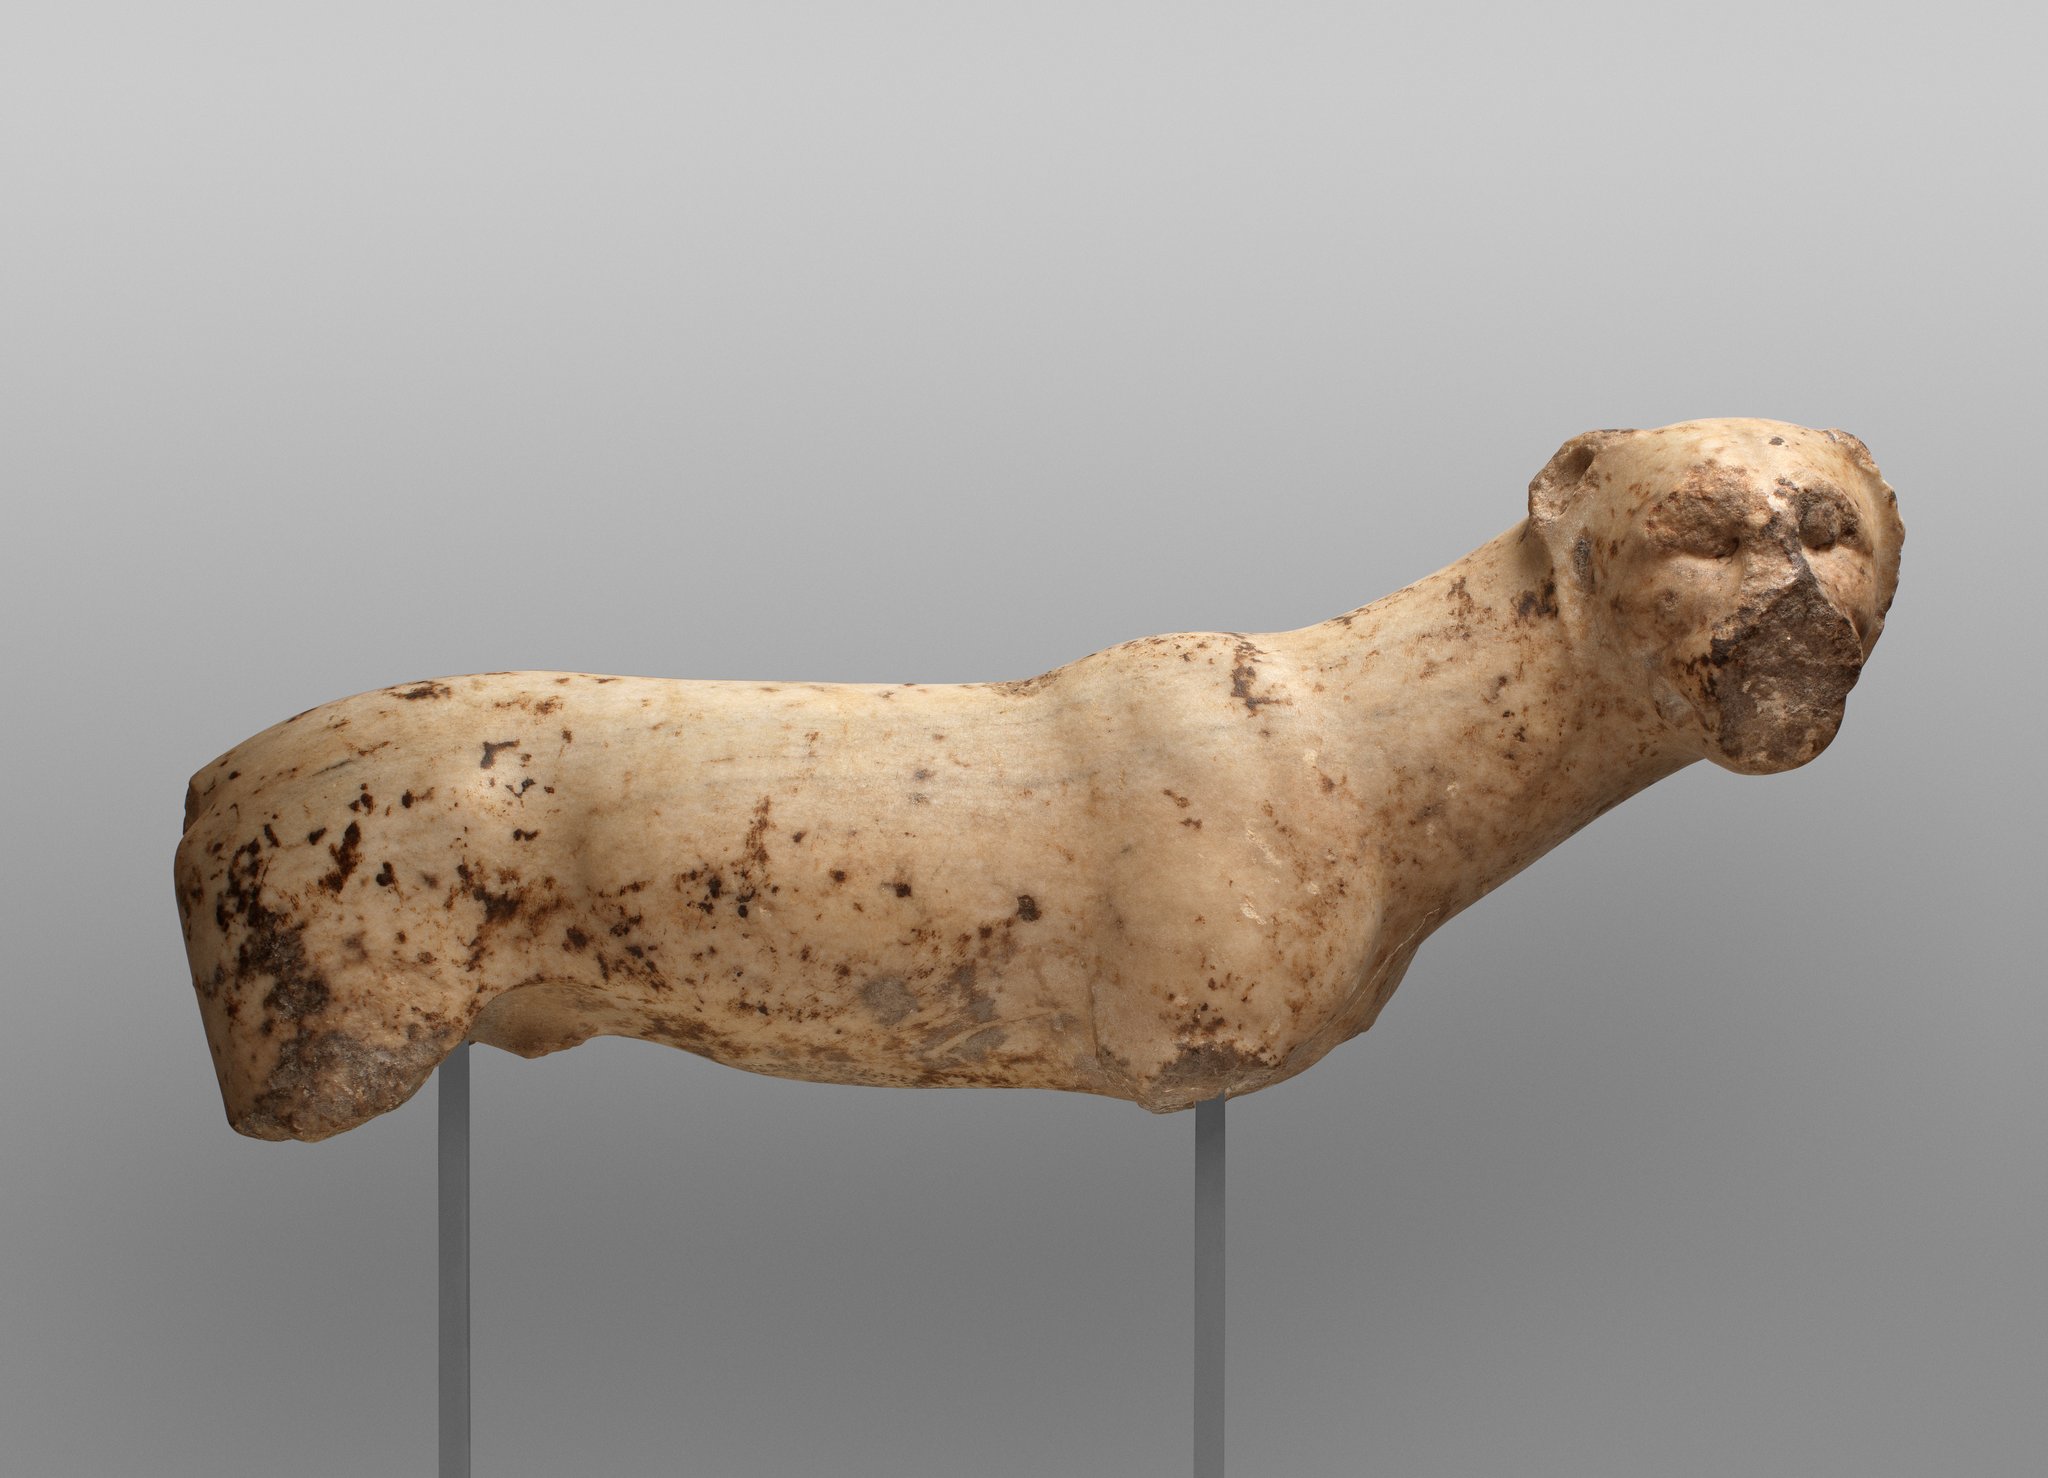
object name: statue of a panther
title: Marble statue of a panther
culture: greek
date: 323-31 BCE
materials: marble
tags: panthers